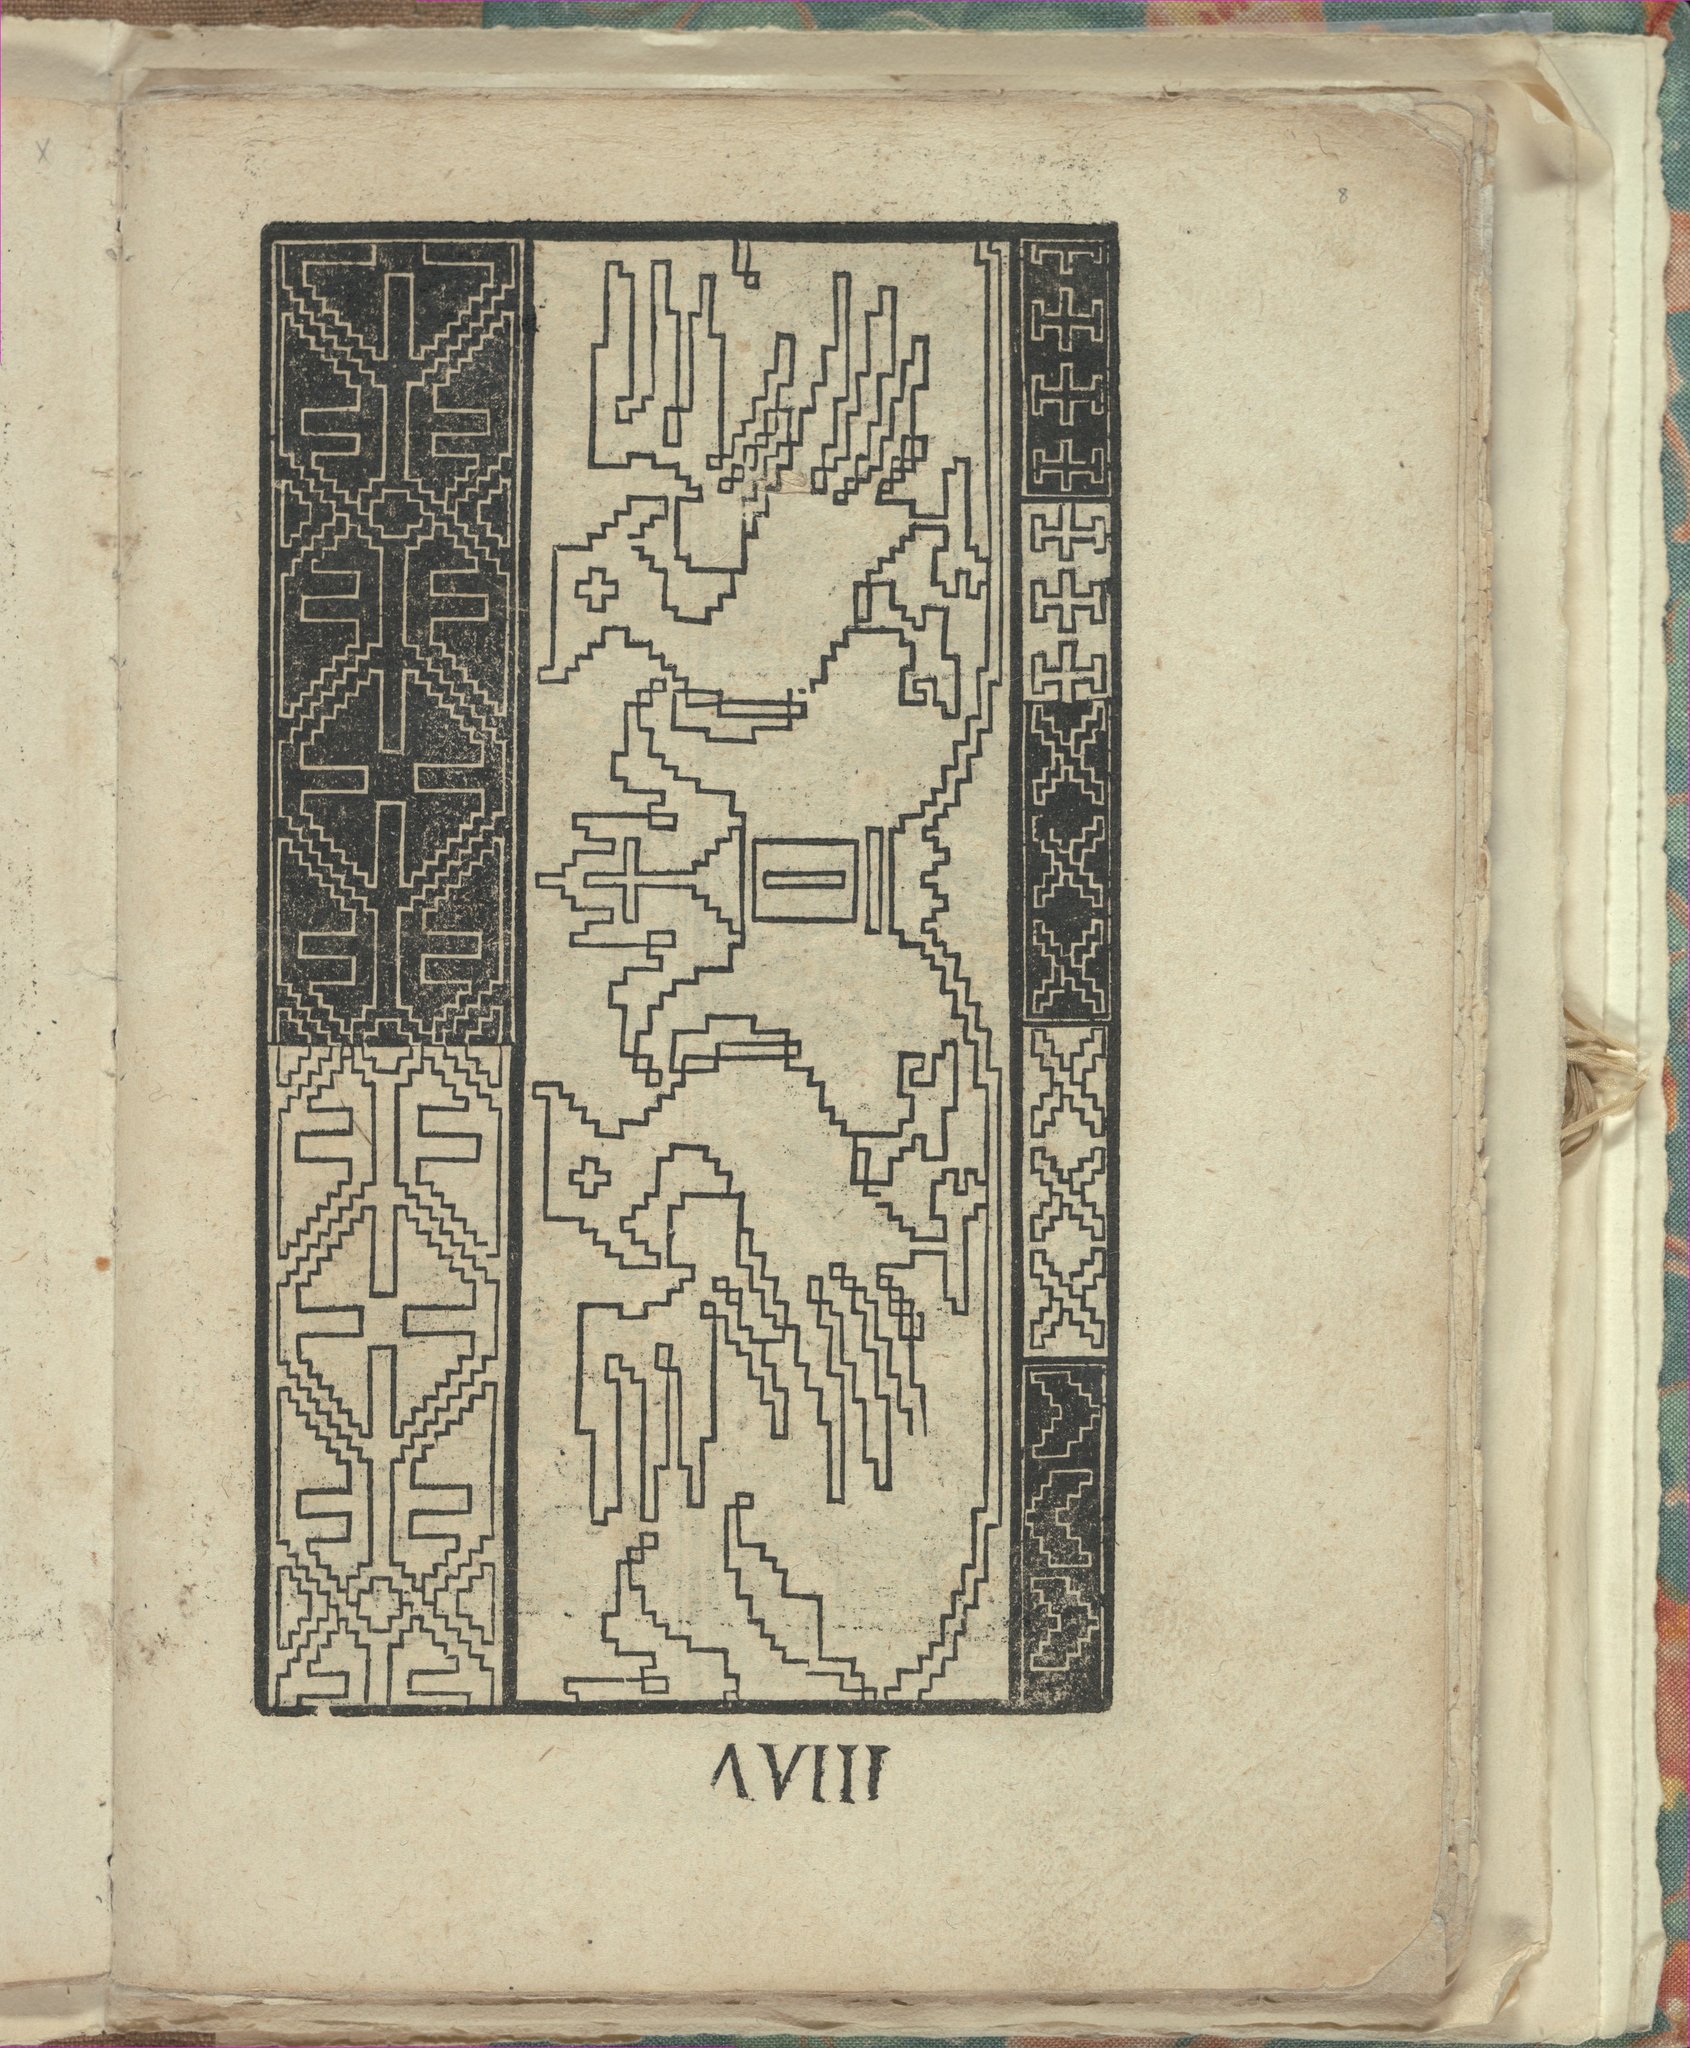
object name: book print ornament architecture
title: Opera Nova Universali intitulata Corona di racammi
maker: giovanni andrea vavassore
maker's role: publisher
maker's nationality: italian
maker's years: 1530-1573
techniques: woodcut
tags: human figures,birds,ornament